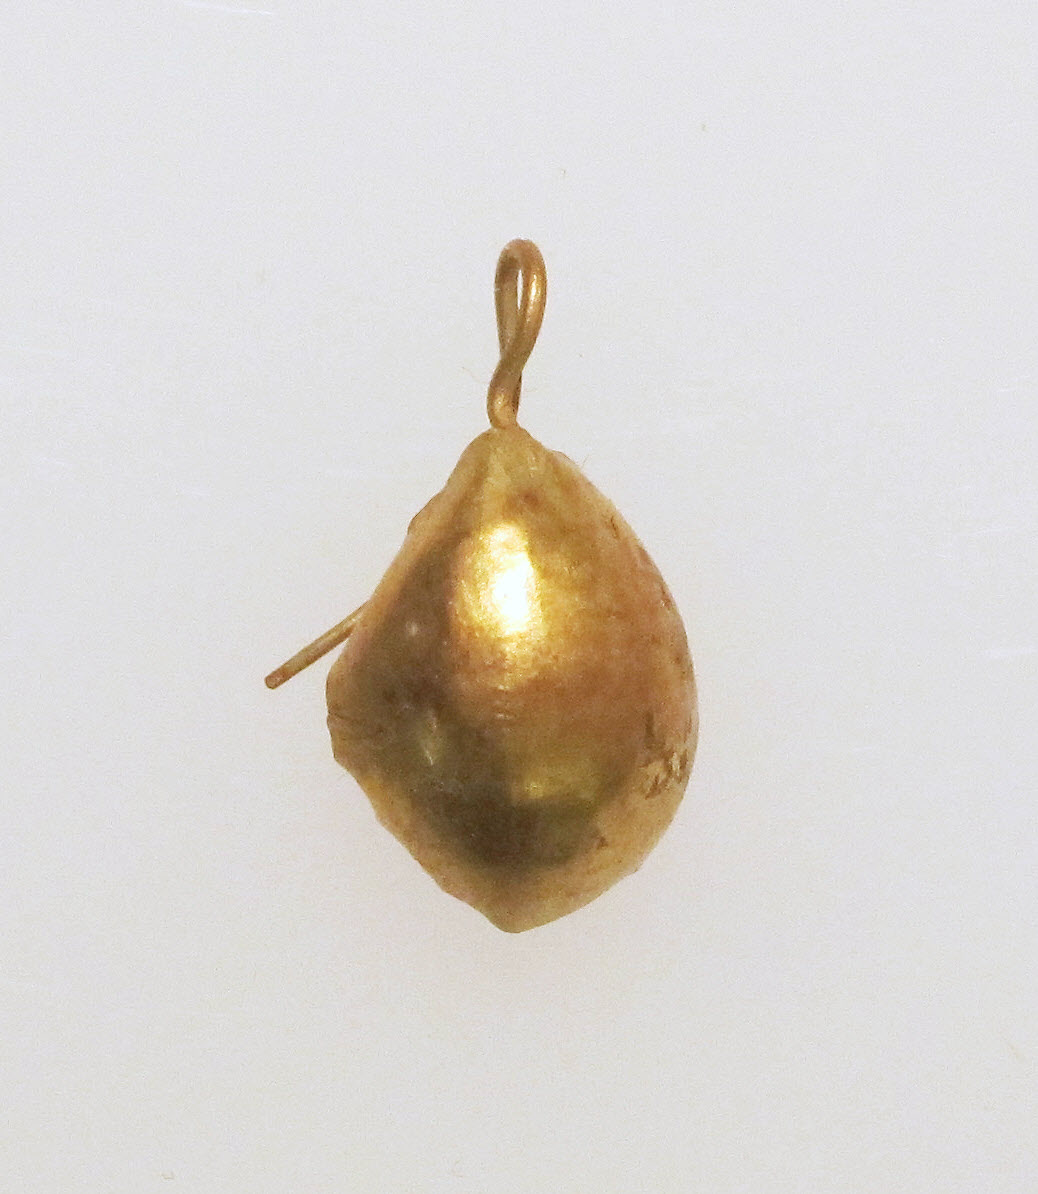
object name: earring hook type with sphere end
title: Earring-hook type with sphere ends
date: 7000 BCE-330 CE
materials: gold